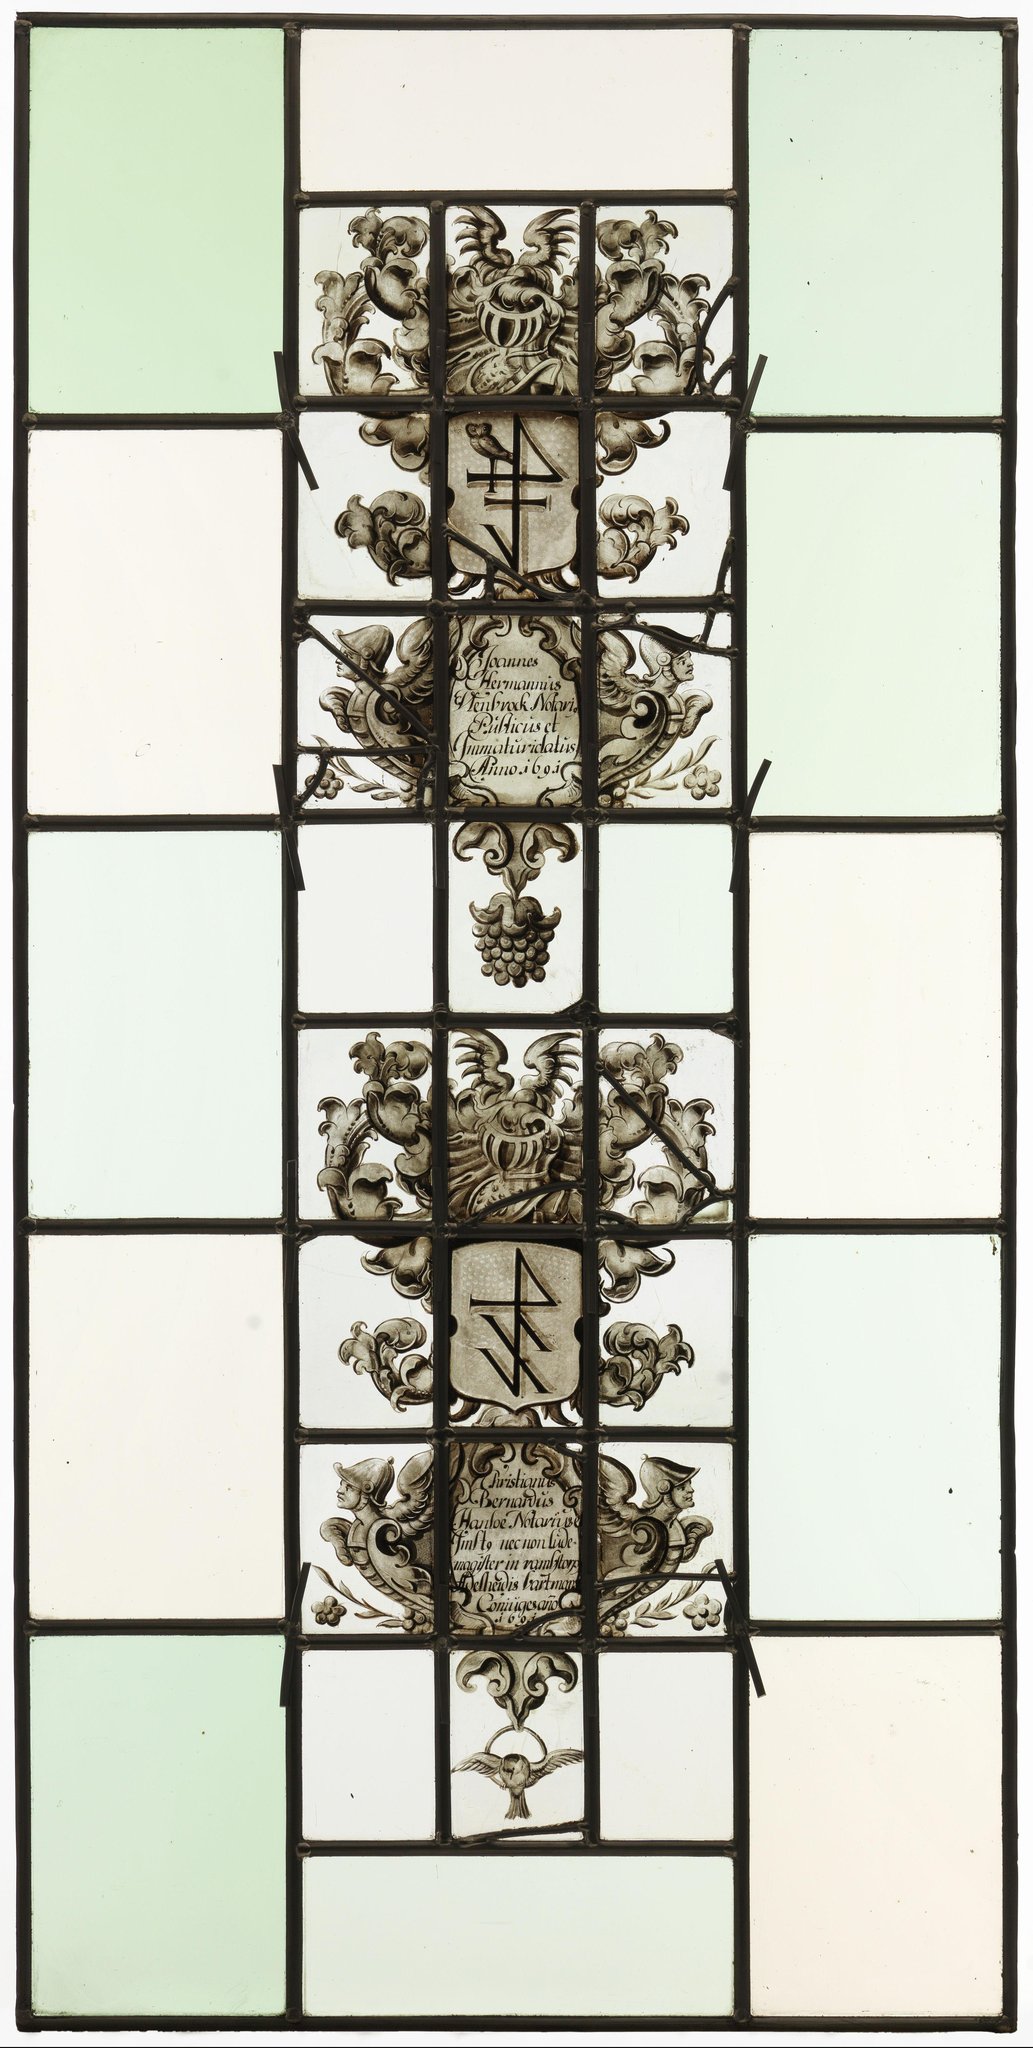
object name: light window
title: Ruit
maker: Anonymous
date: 1699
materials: glass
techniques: enamel painting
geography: westphalia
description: Ruit met gebrandschilderde voorstelling, zit vast aan BK-2000-10-K.